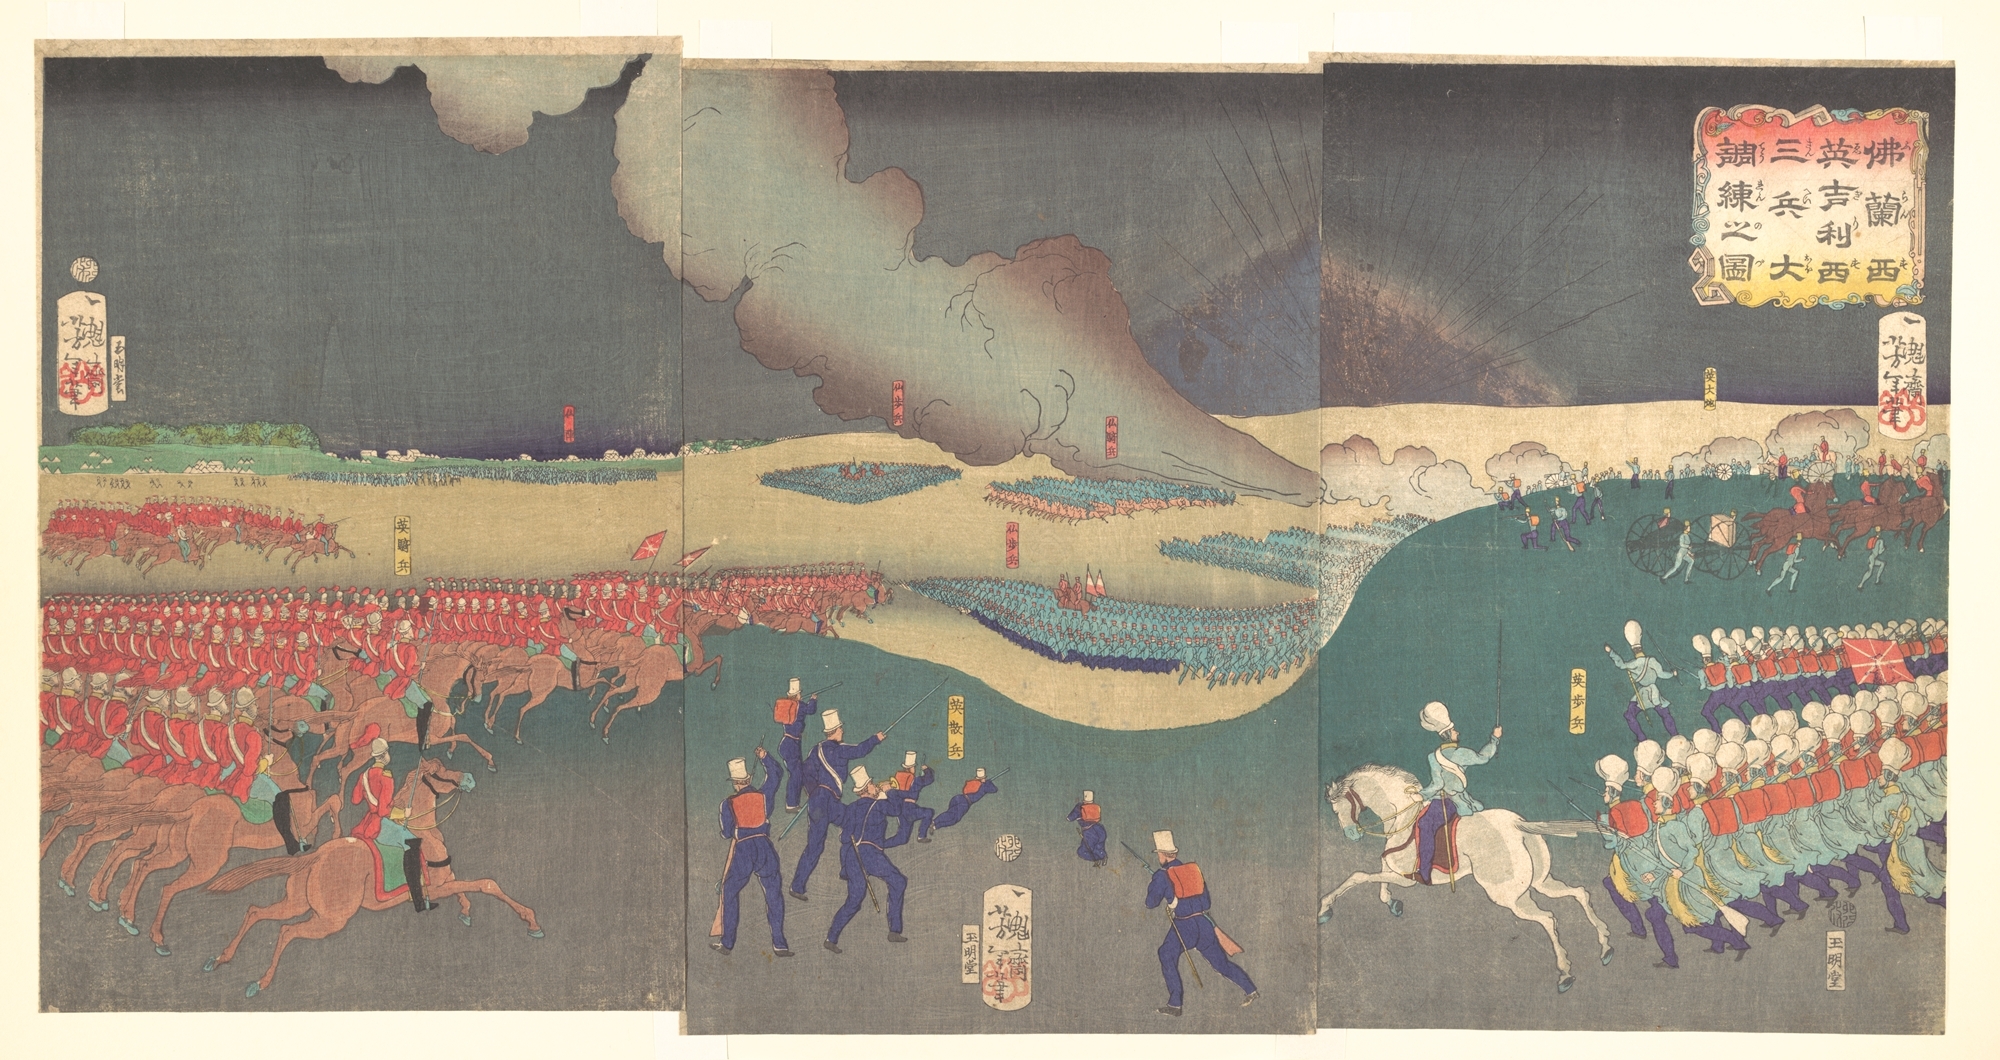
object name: print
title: Maneuvers by Three Categories of French and English Soldiers (Furansu Igirisu sanhei ōchōren no zu)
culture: japanese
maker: tsukioka yoshitoshi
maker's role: artist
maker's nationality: japanese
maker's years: 1839-1892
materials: ink, paper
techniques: woodblock print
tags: battles,soldiers,horses